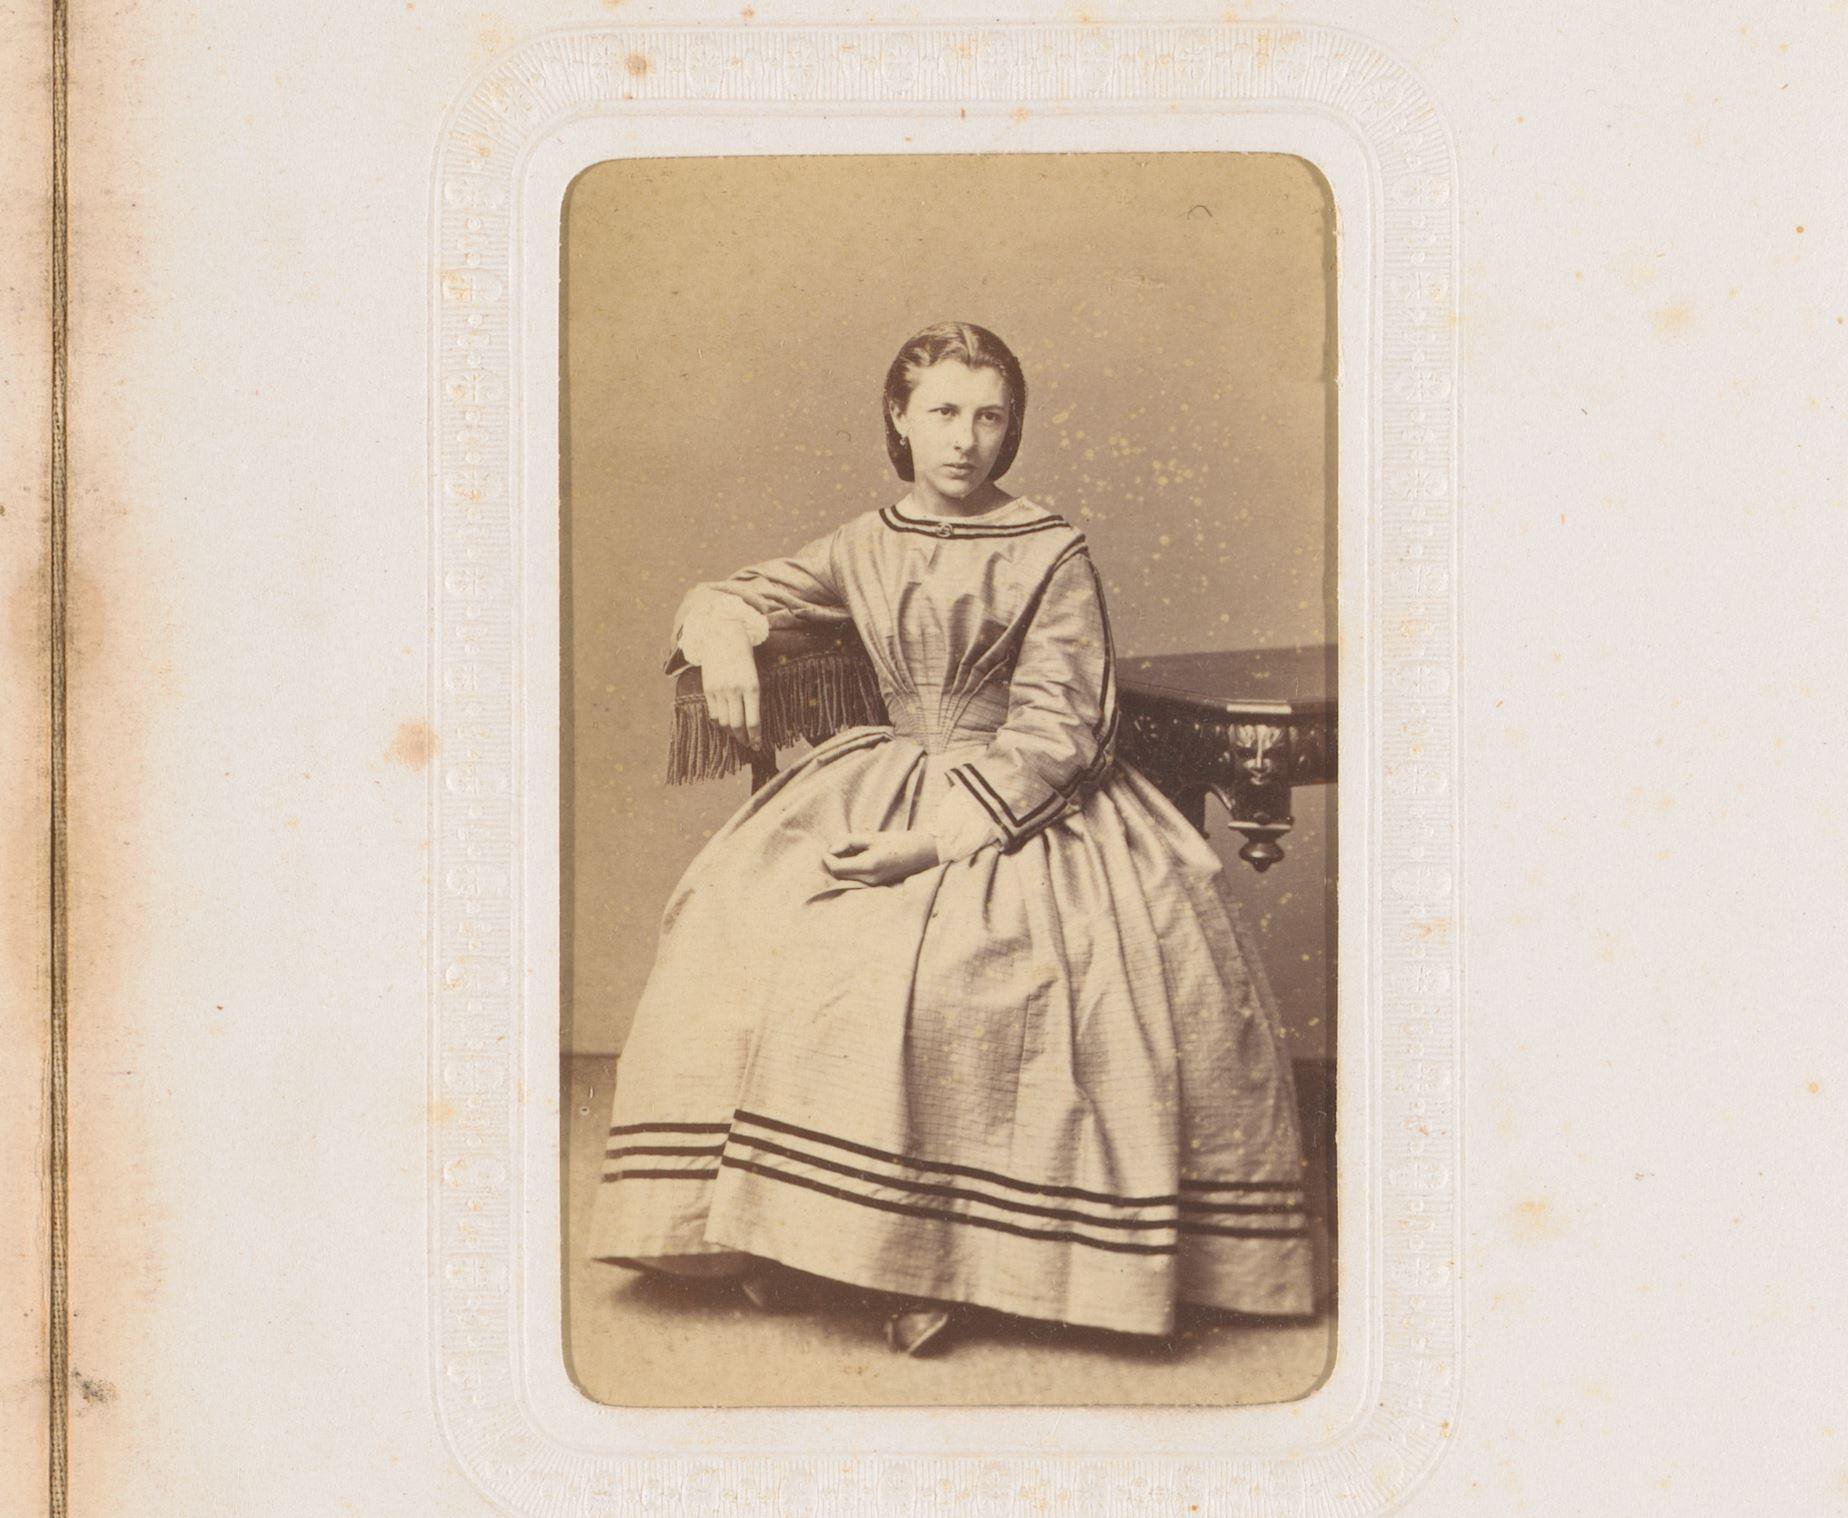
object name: photograph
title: Portret van een zittende jonge vrouw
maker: Anonymous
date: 1860-1900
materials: cardboard, photographic support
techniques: albumen print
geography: netherlands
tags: adolescent, young woman, maiden, sitting figure - aa - female human figure, historical persons - bb - woman